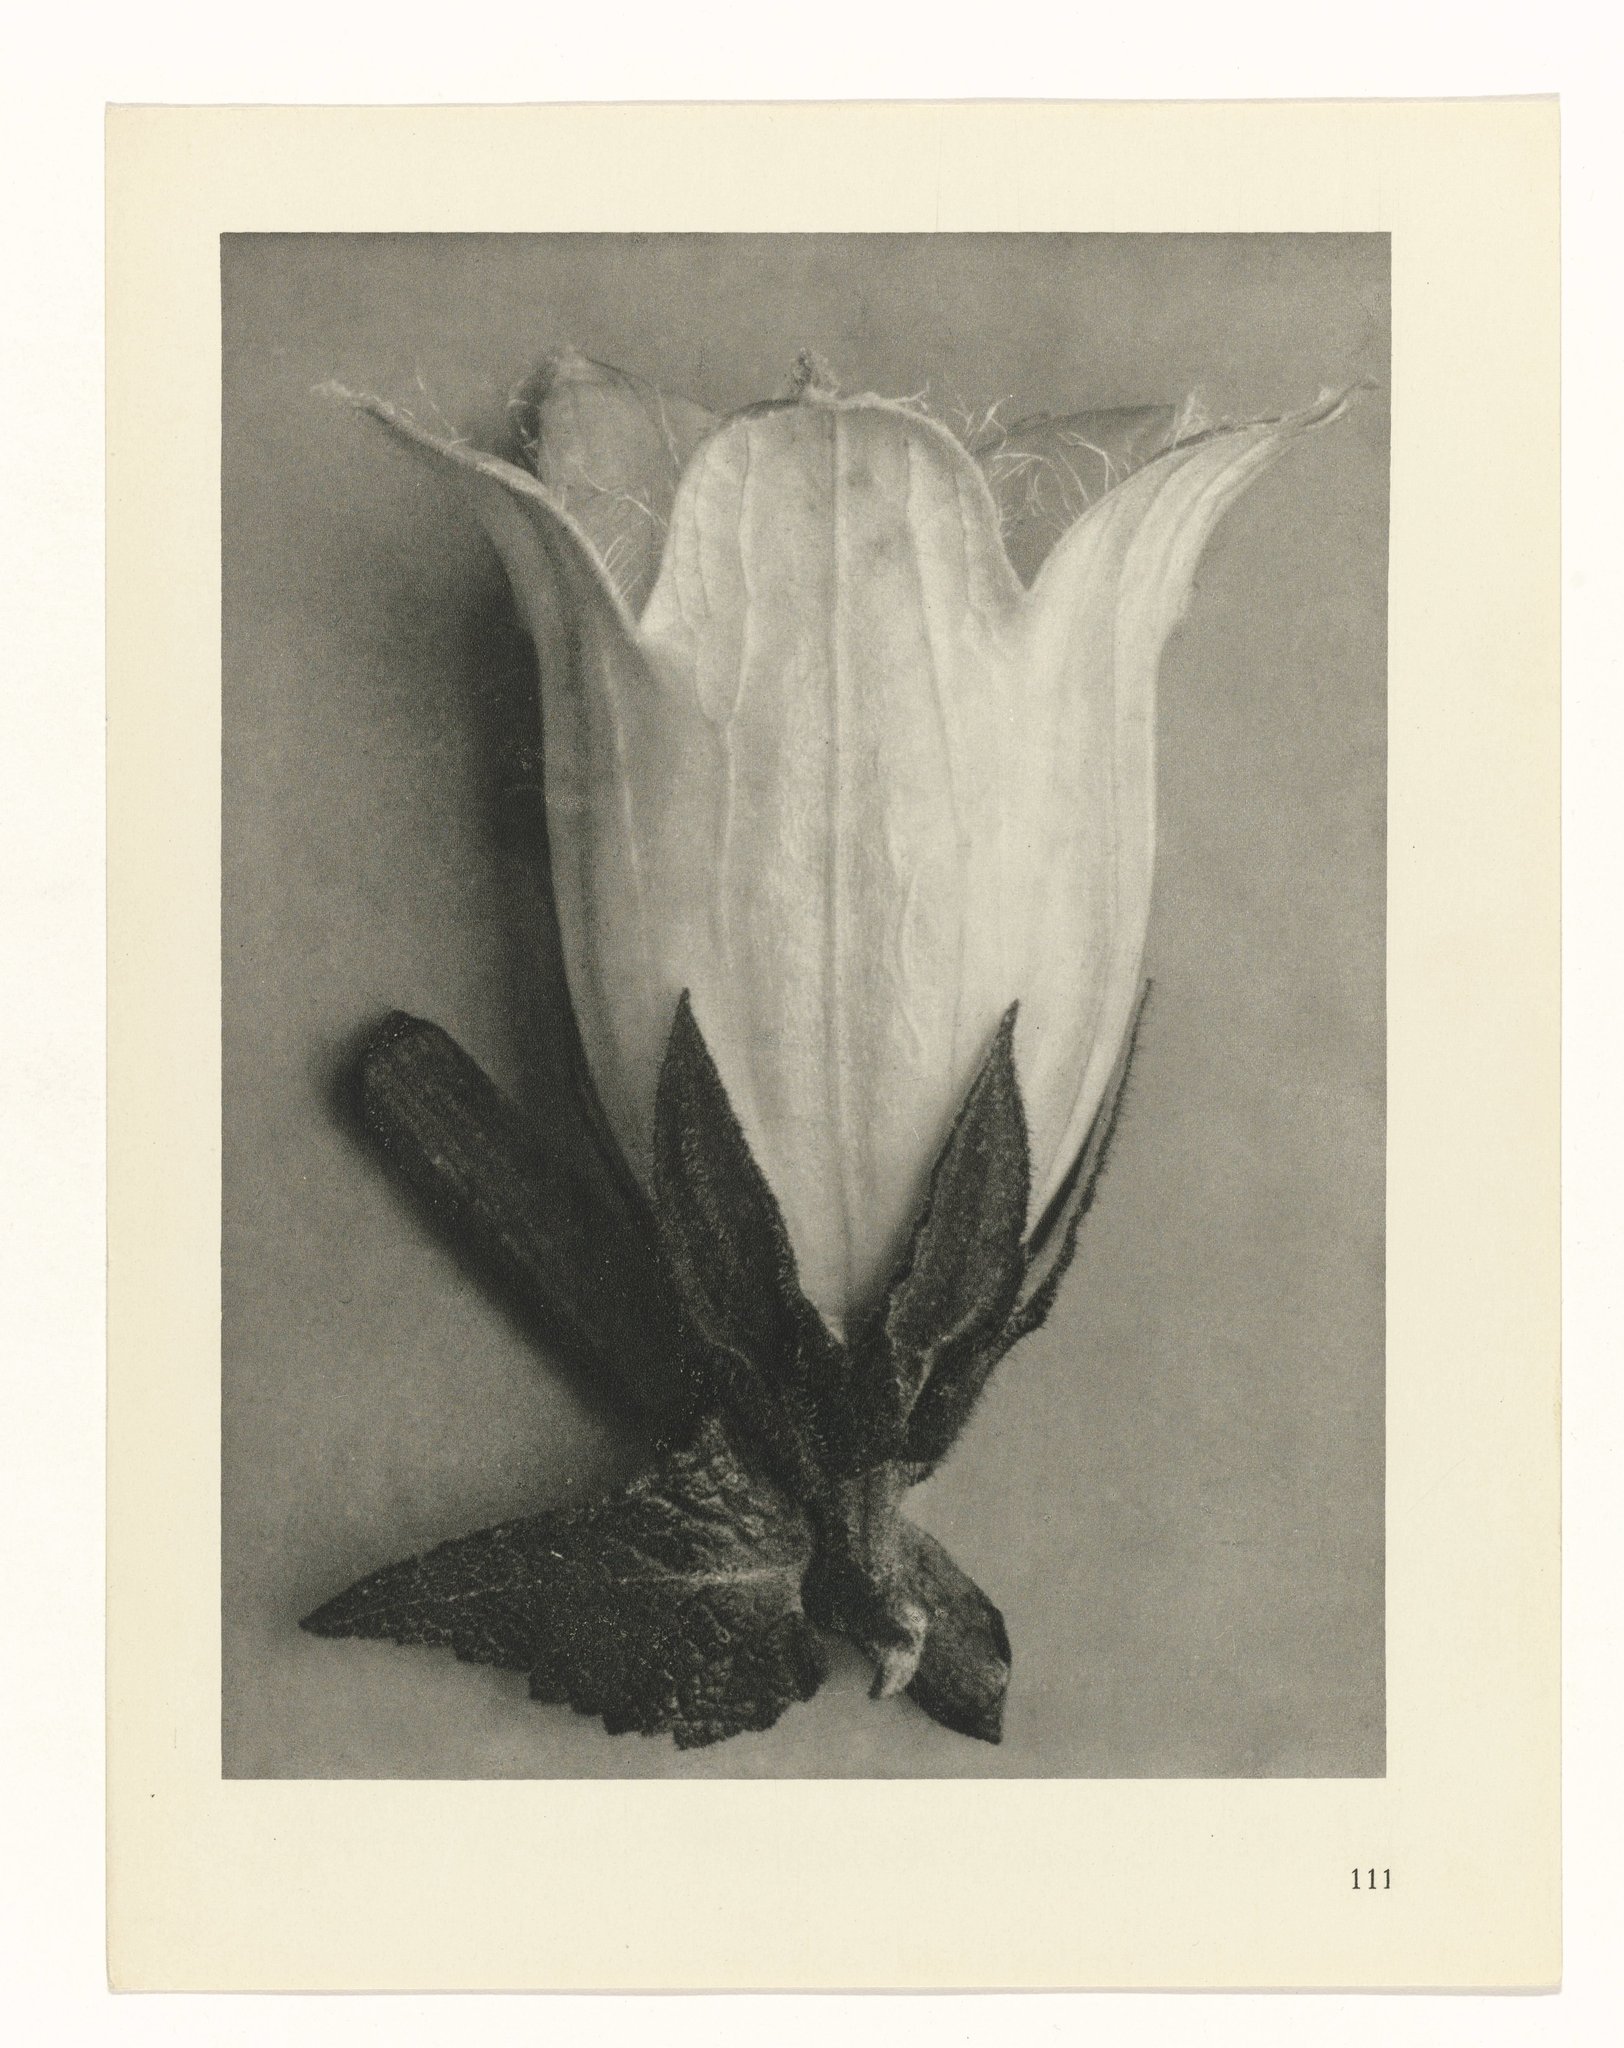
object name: photograph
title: Plant Studies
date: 1928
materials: ink, paper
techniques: rotogravure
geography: berlin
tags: plants (in general)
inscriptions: number: ‘111’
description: facher Vergrößerung. Afkomstig uit losbladige uitgave.